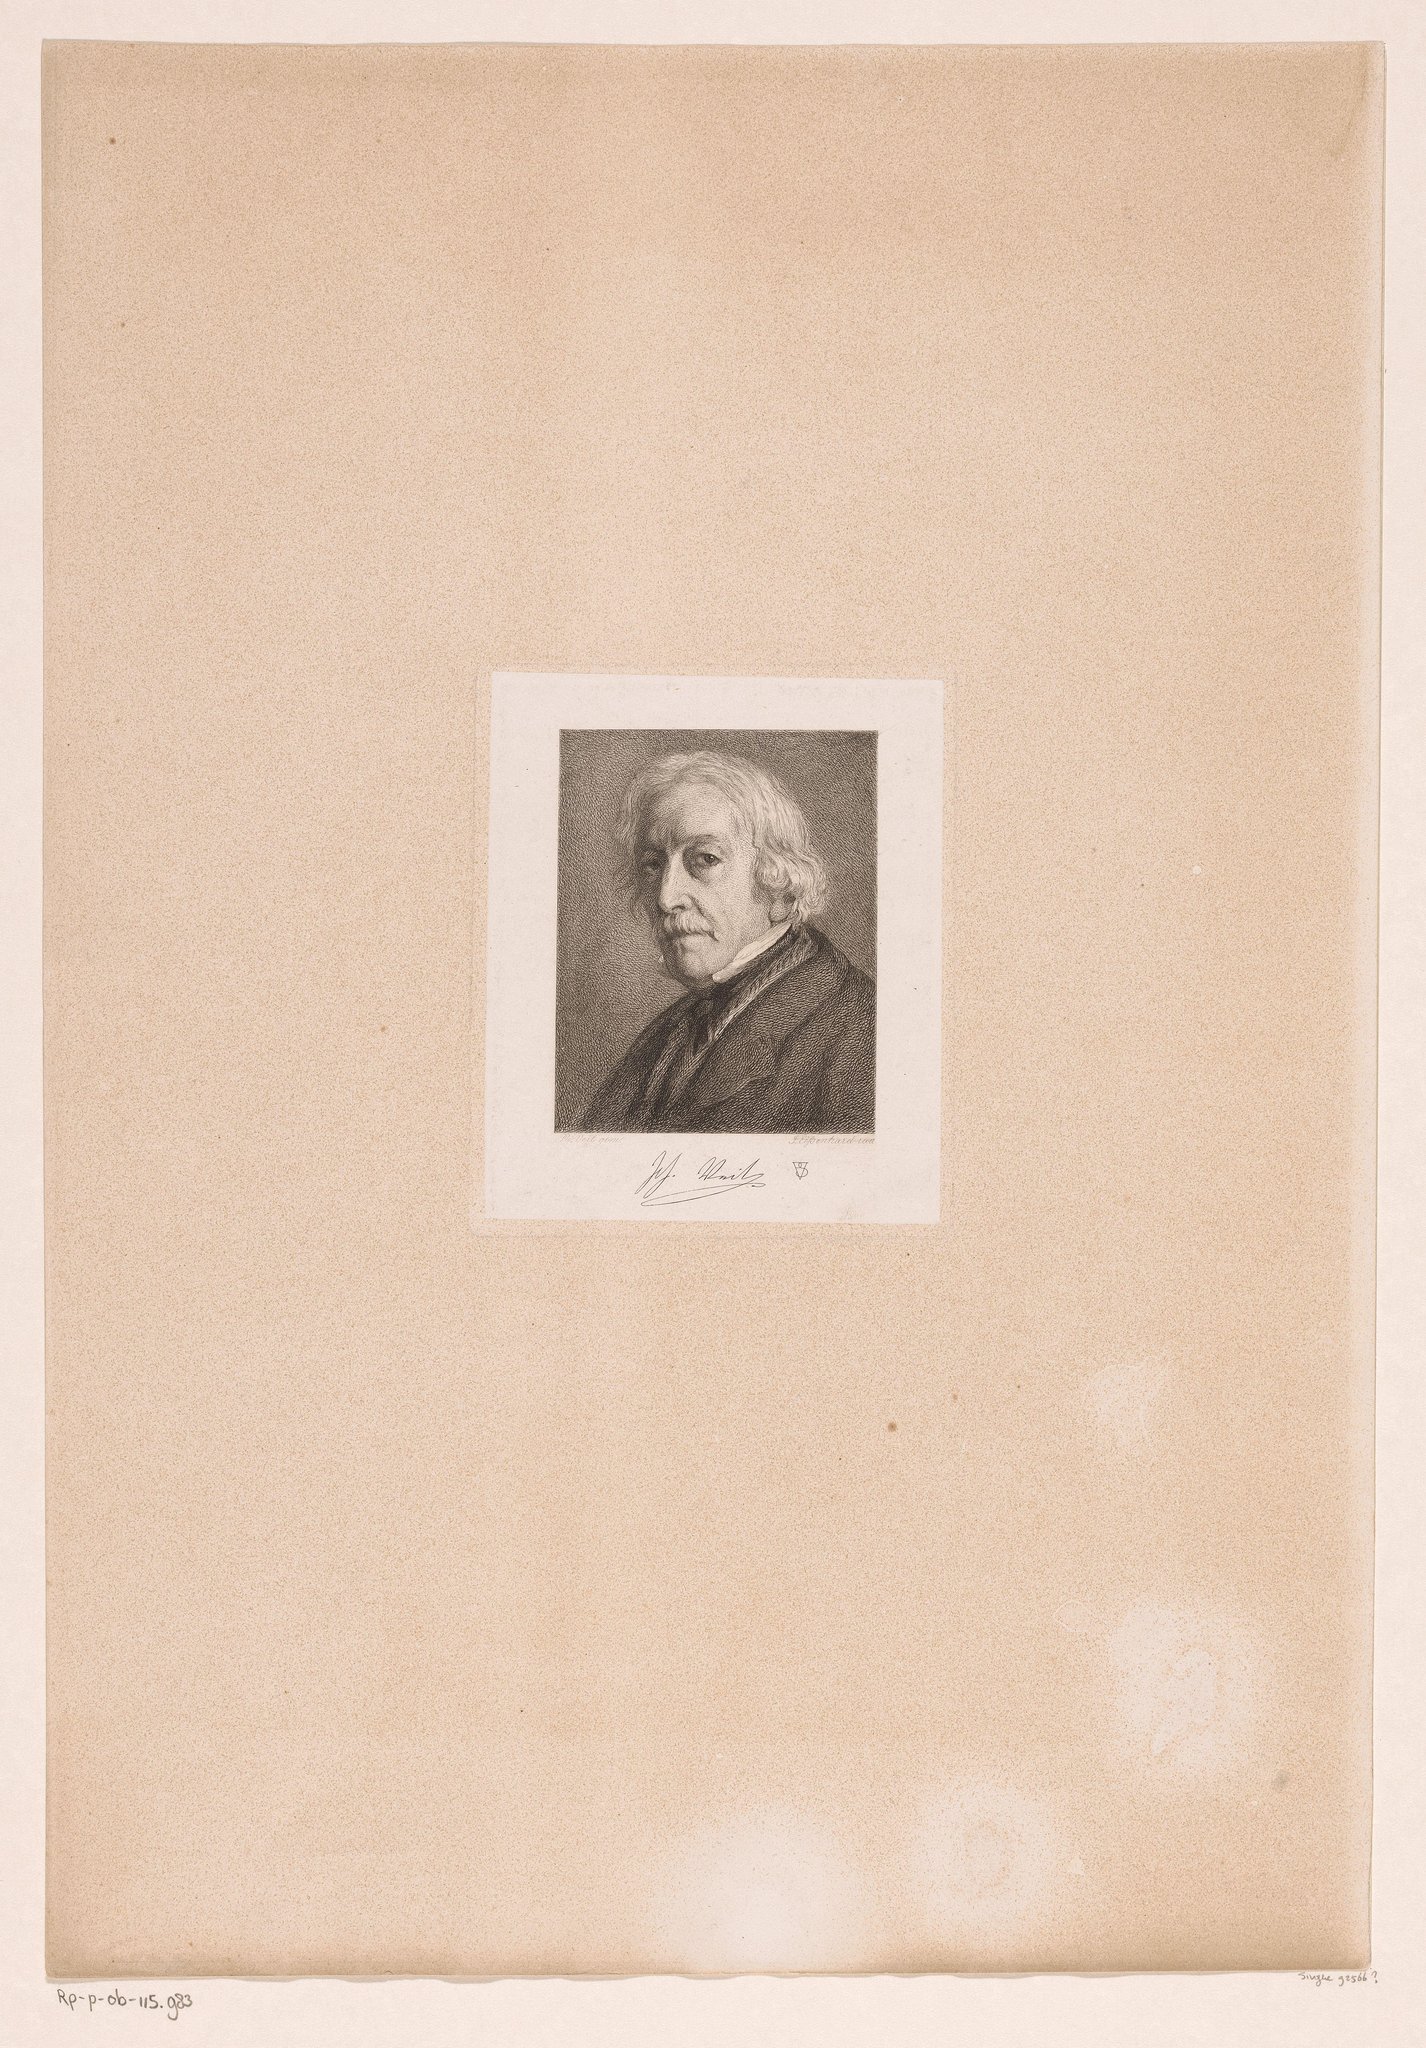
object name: print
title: Portret van Johannes Veit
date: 1834-1896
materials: paper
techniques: etching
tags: painter, historical persons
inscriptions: collector's mark: Lugt 2228